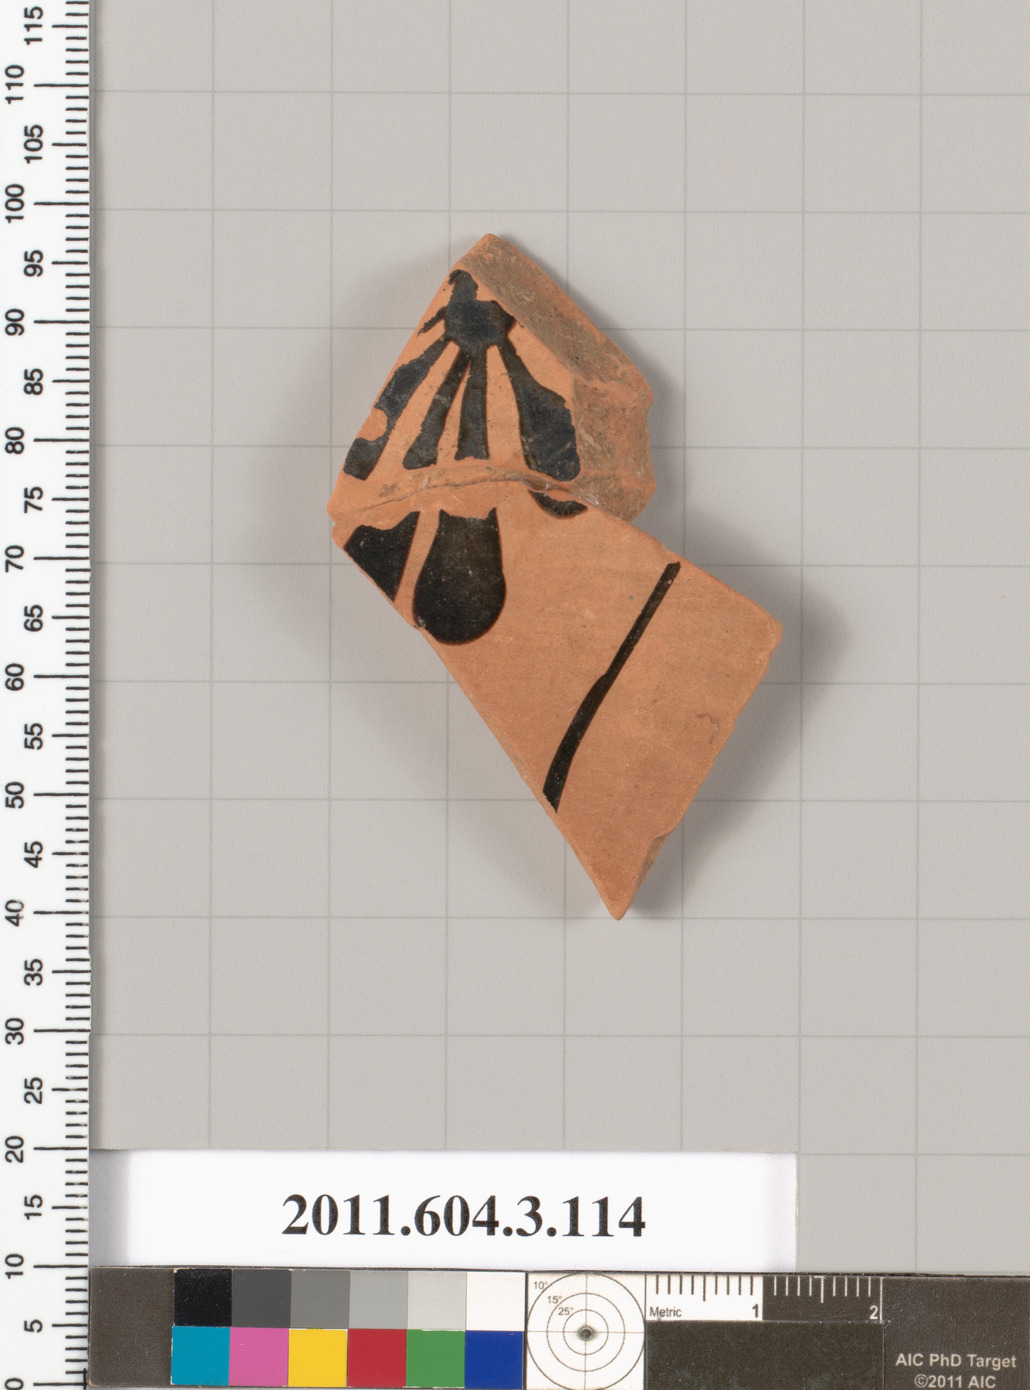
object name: amphora fragment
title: Terracotta fragment of an amphora (jar)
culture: greek, attic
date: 540-530 BCE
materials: terracotta